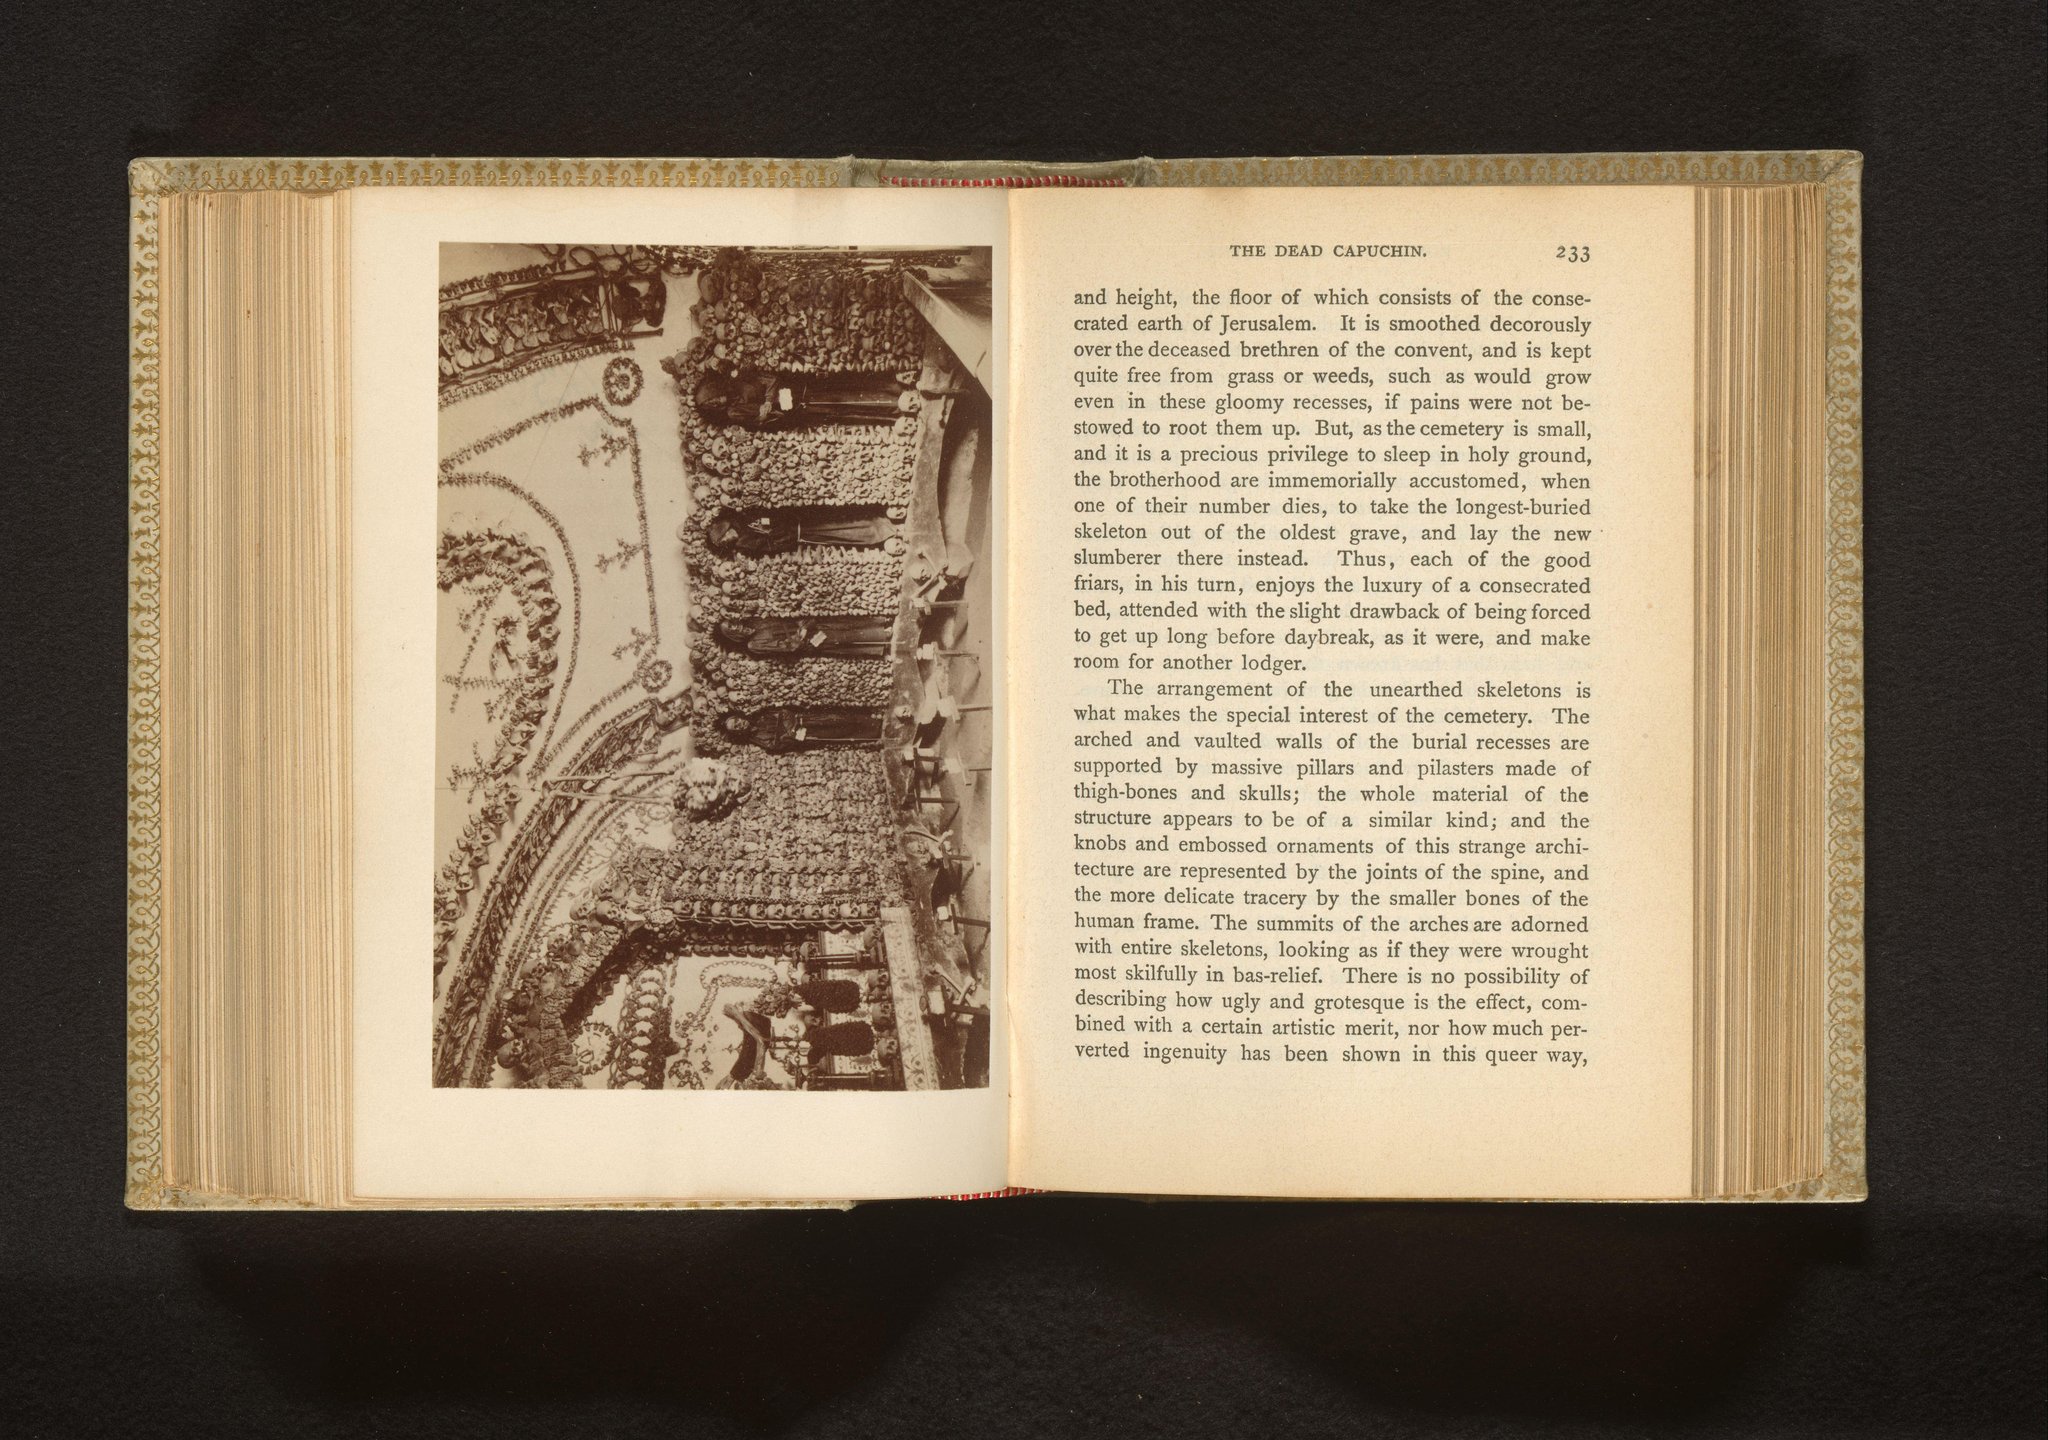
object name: page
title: Ossuarium in de Santa Maria della Concezione dei Cappuccini in Rome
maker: Anonymous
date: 1850-1860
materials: photographic support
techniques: albumen print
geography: santa maria della concezione dei cappuccini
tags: charnelhouse, ossuary